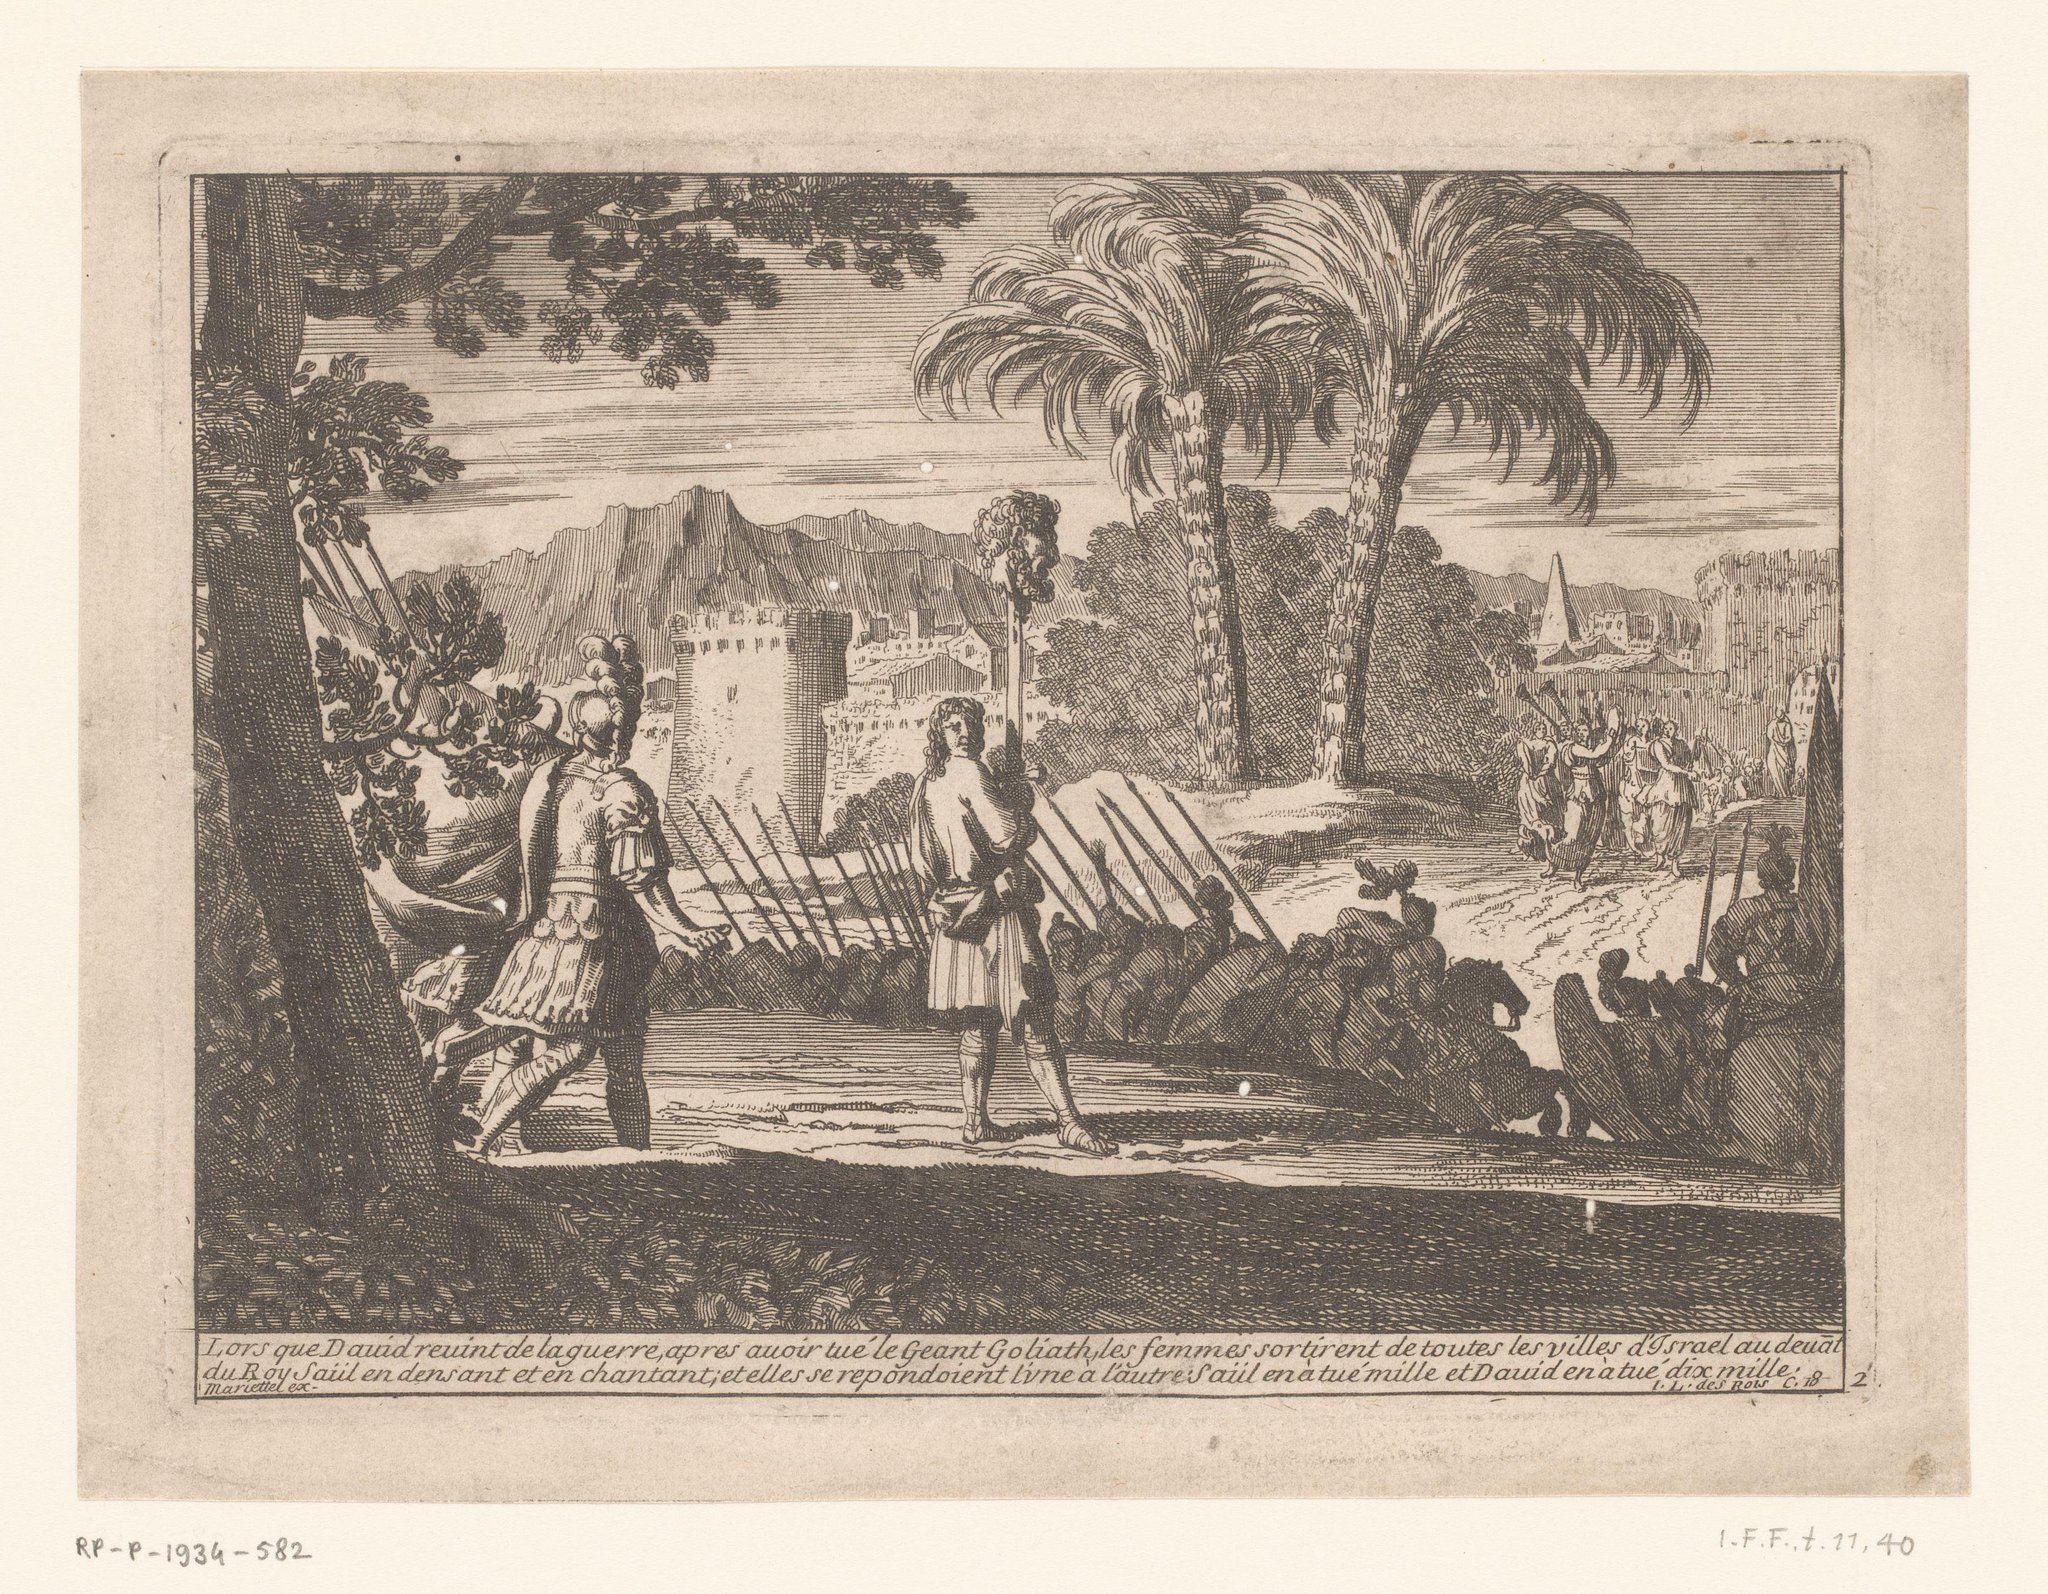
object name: print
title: David met het hoofd van Goliath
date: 1628-1682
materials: paper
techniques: etching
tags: david with goliath's head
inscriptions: collector's mark: Lugt 2228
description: Maakt deel uit van een vierdelige serie met scènes uit het verhaal van David en Paul.